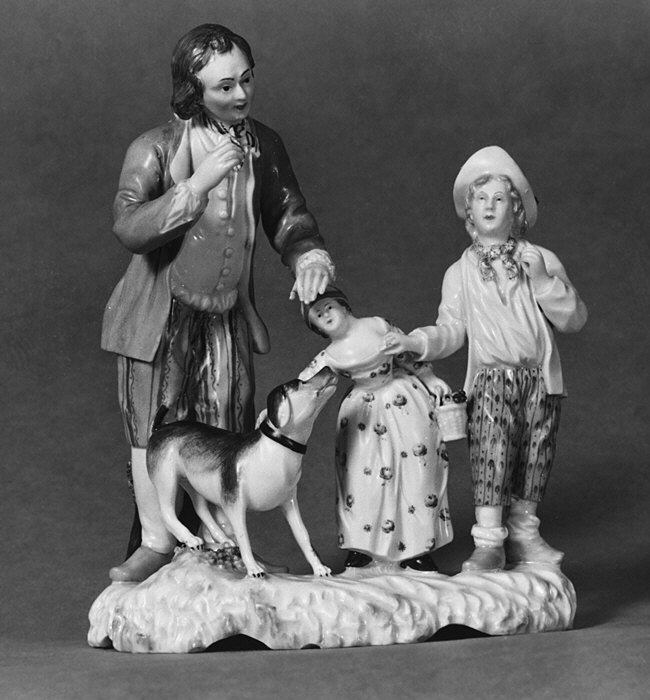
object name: group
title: Education of a Peasant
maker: höchst manufactory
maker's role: manufactory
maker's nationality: german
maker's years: 1746-1796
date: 1755-1760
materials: hard paste porcelain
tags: girls,men,dogs